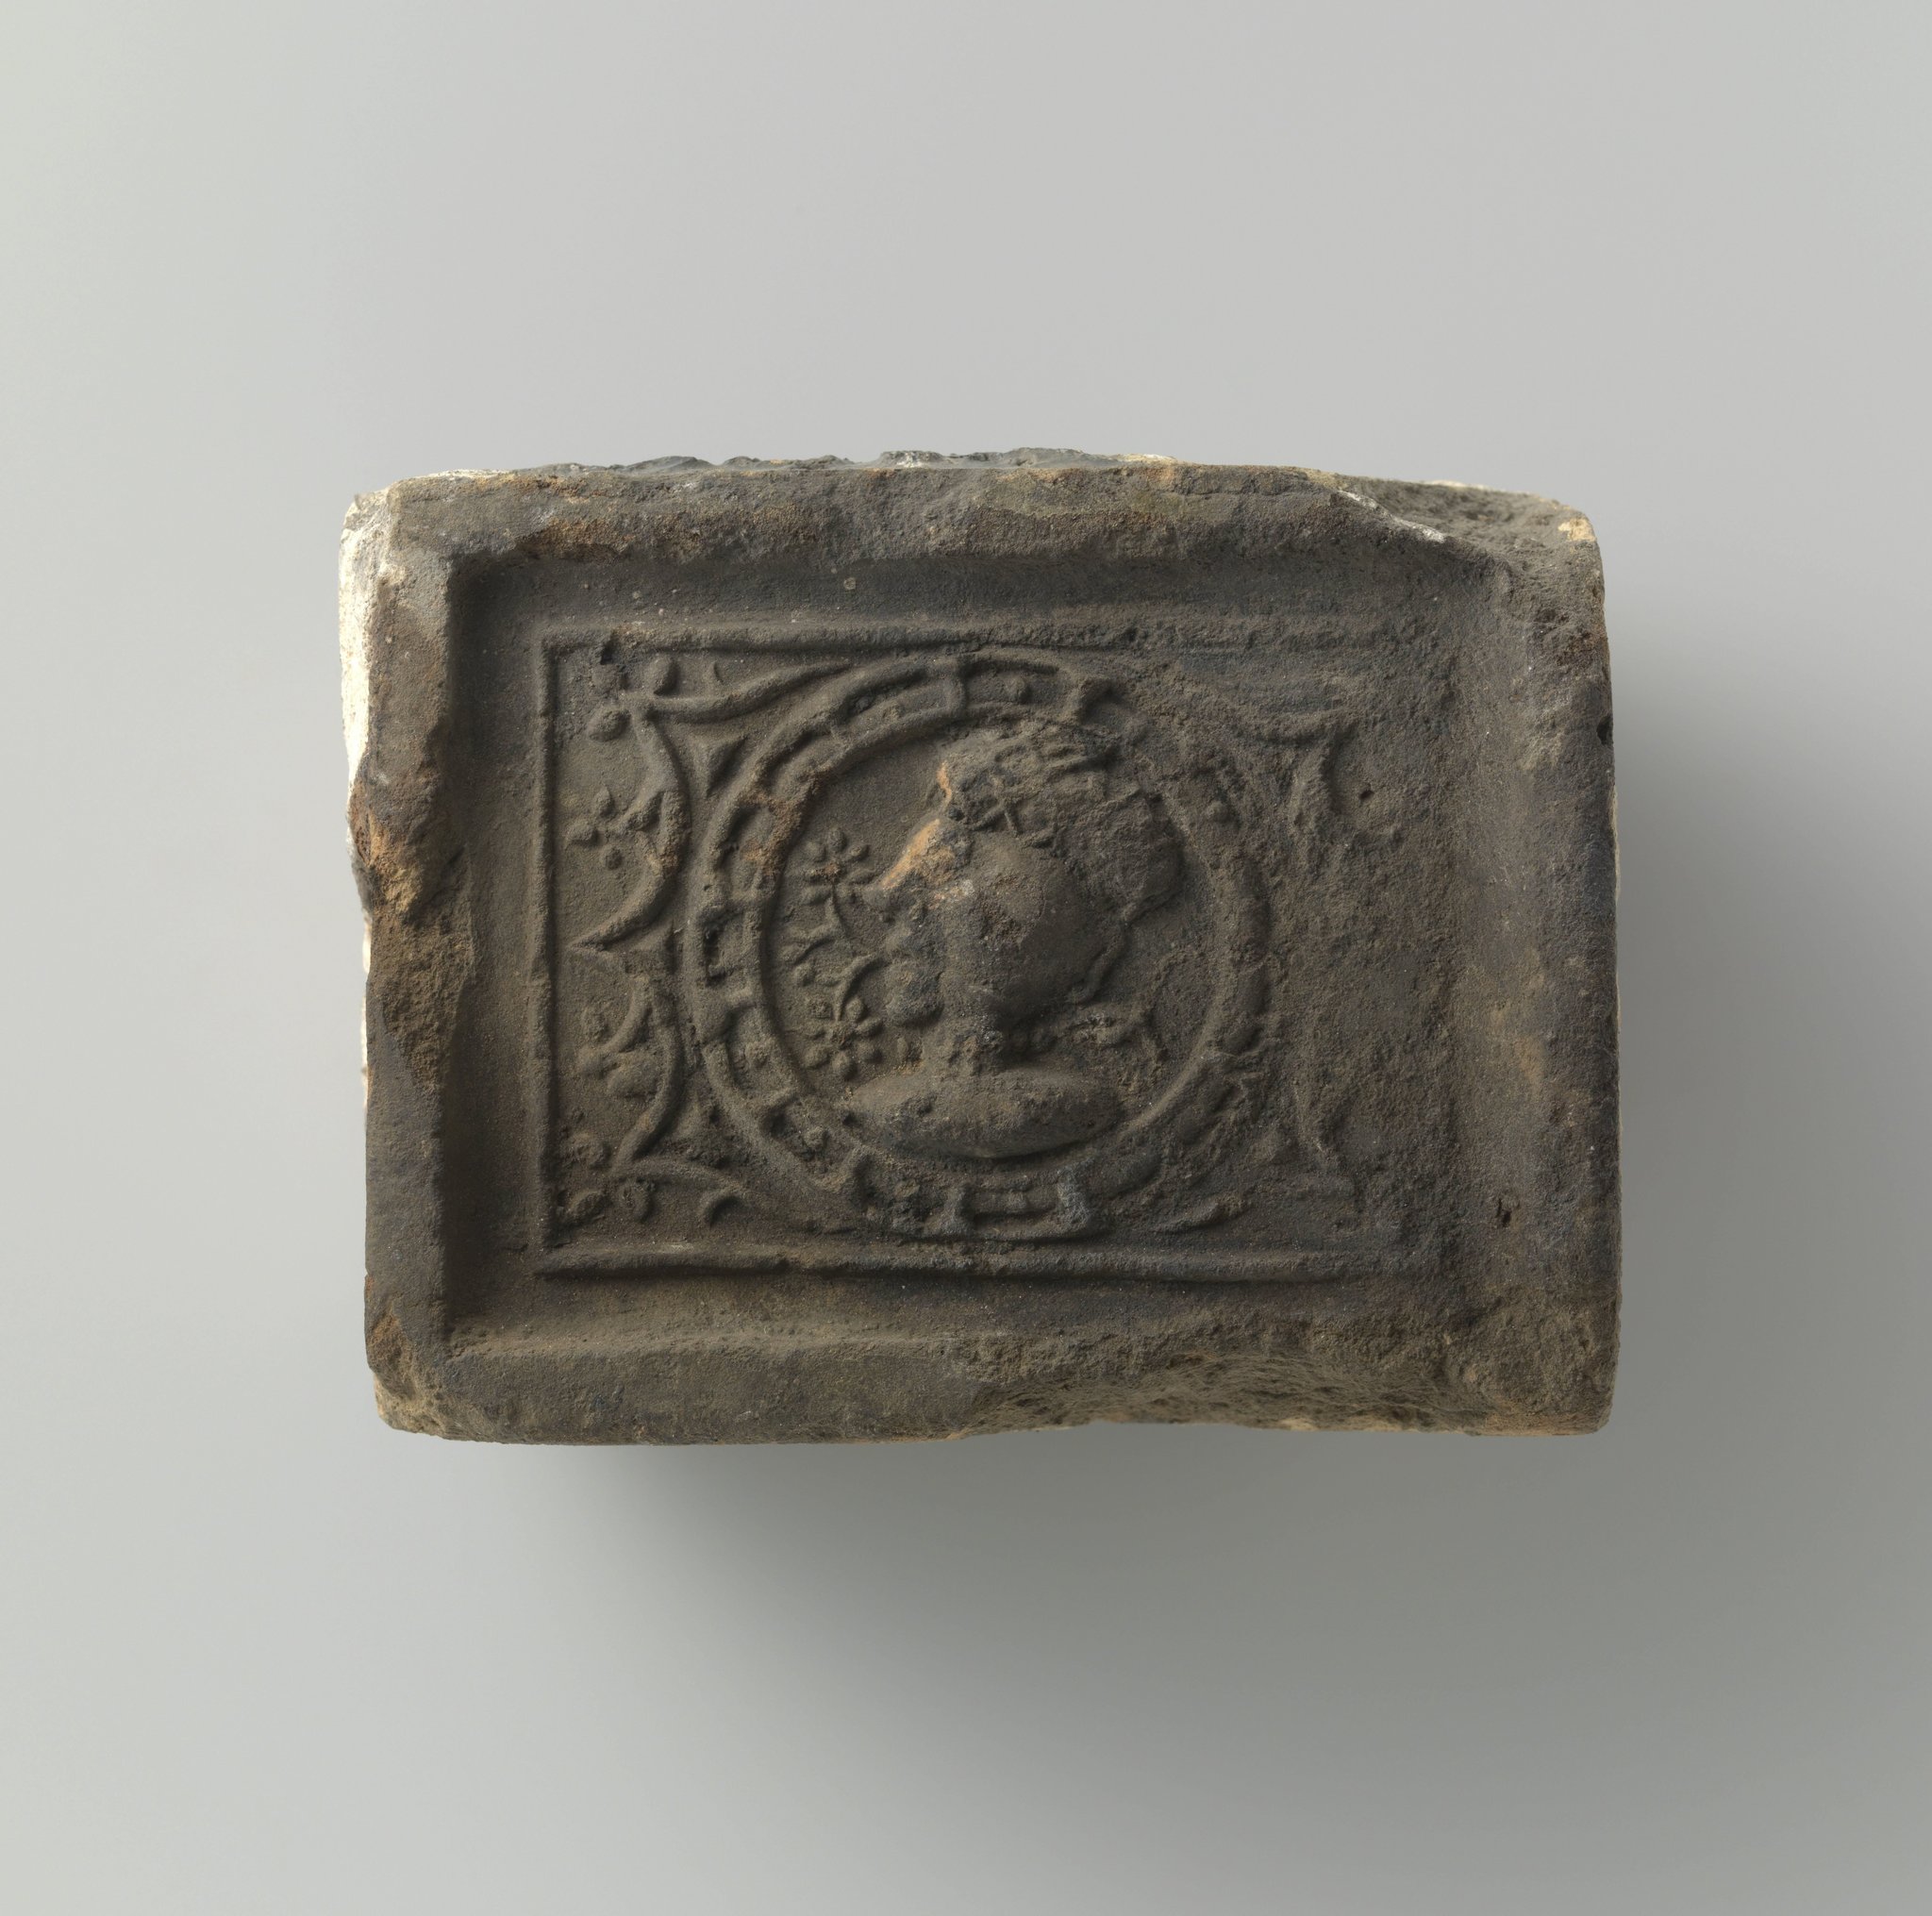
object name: architectural element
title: Haardsteen, waarop in een medaillon een portret met opvallende haardos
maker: Anonymous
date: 1400-1950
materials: earthenware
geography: southern netherlands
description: Haardsteen, waarop in een medaillon een portret met opvallende haardos. In laat gothische rand. Van fijne gebakken aarde.